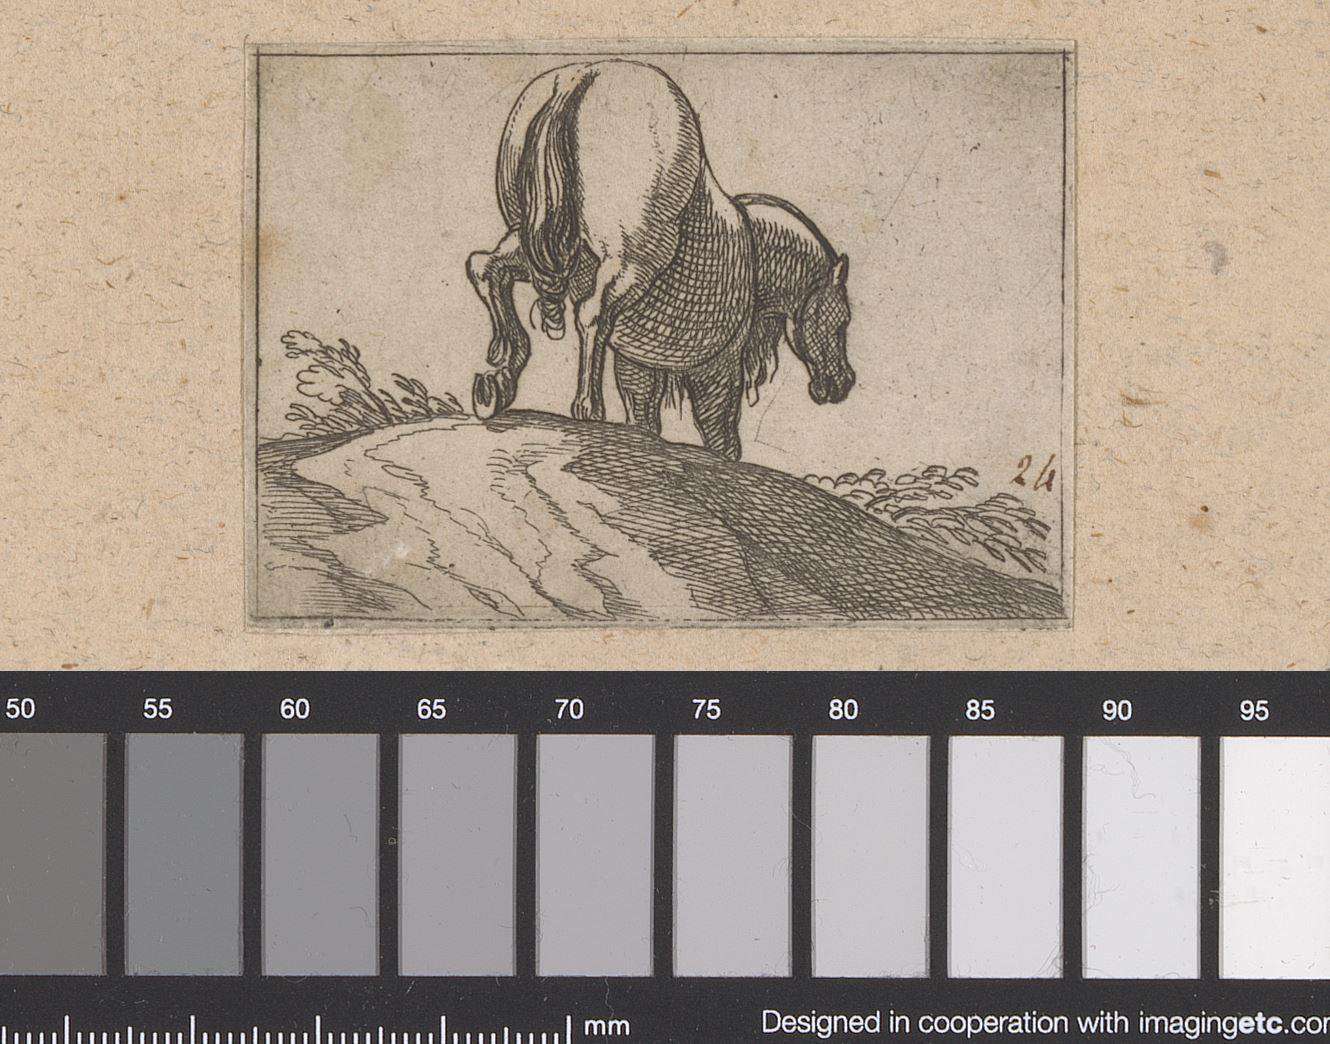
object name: print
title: Paard over een heuveltje lopend van achteren gezien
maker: antonio tempesta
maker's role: draughtsman, painter, print maker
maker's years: 1555-1630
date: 1565-1630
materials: paper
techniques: etching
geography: italy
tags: horse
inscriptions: collector's mark: Lugt 11, number: ‘24’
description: Deze prent maakt deel uit van een reeks van 24 prenten van paarden.